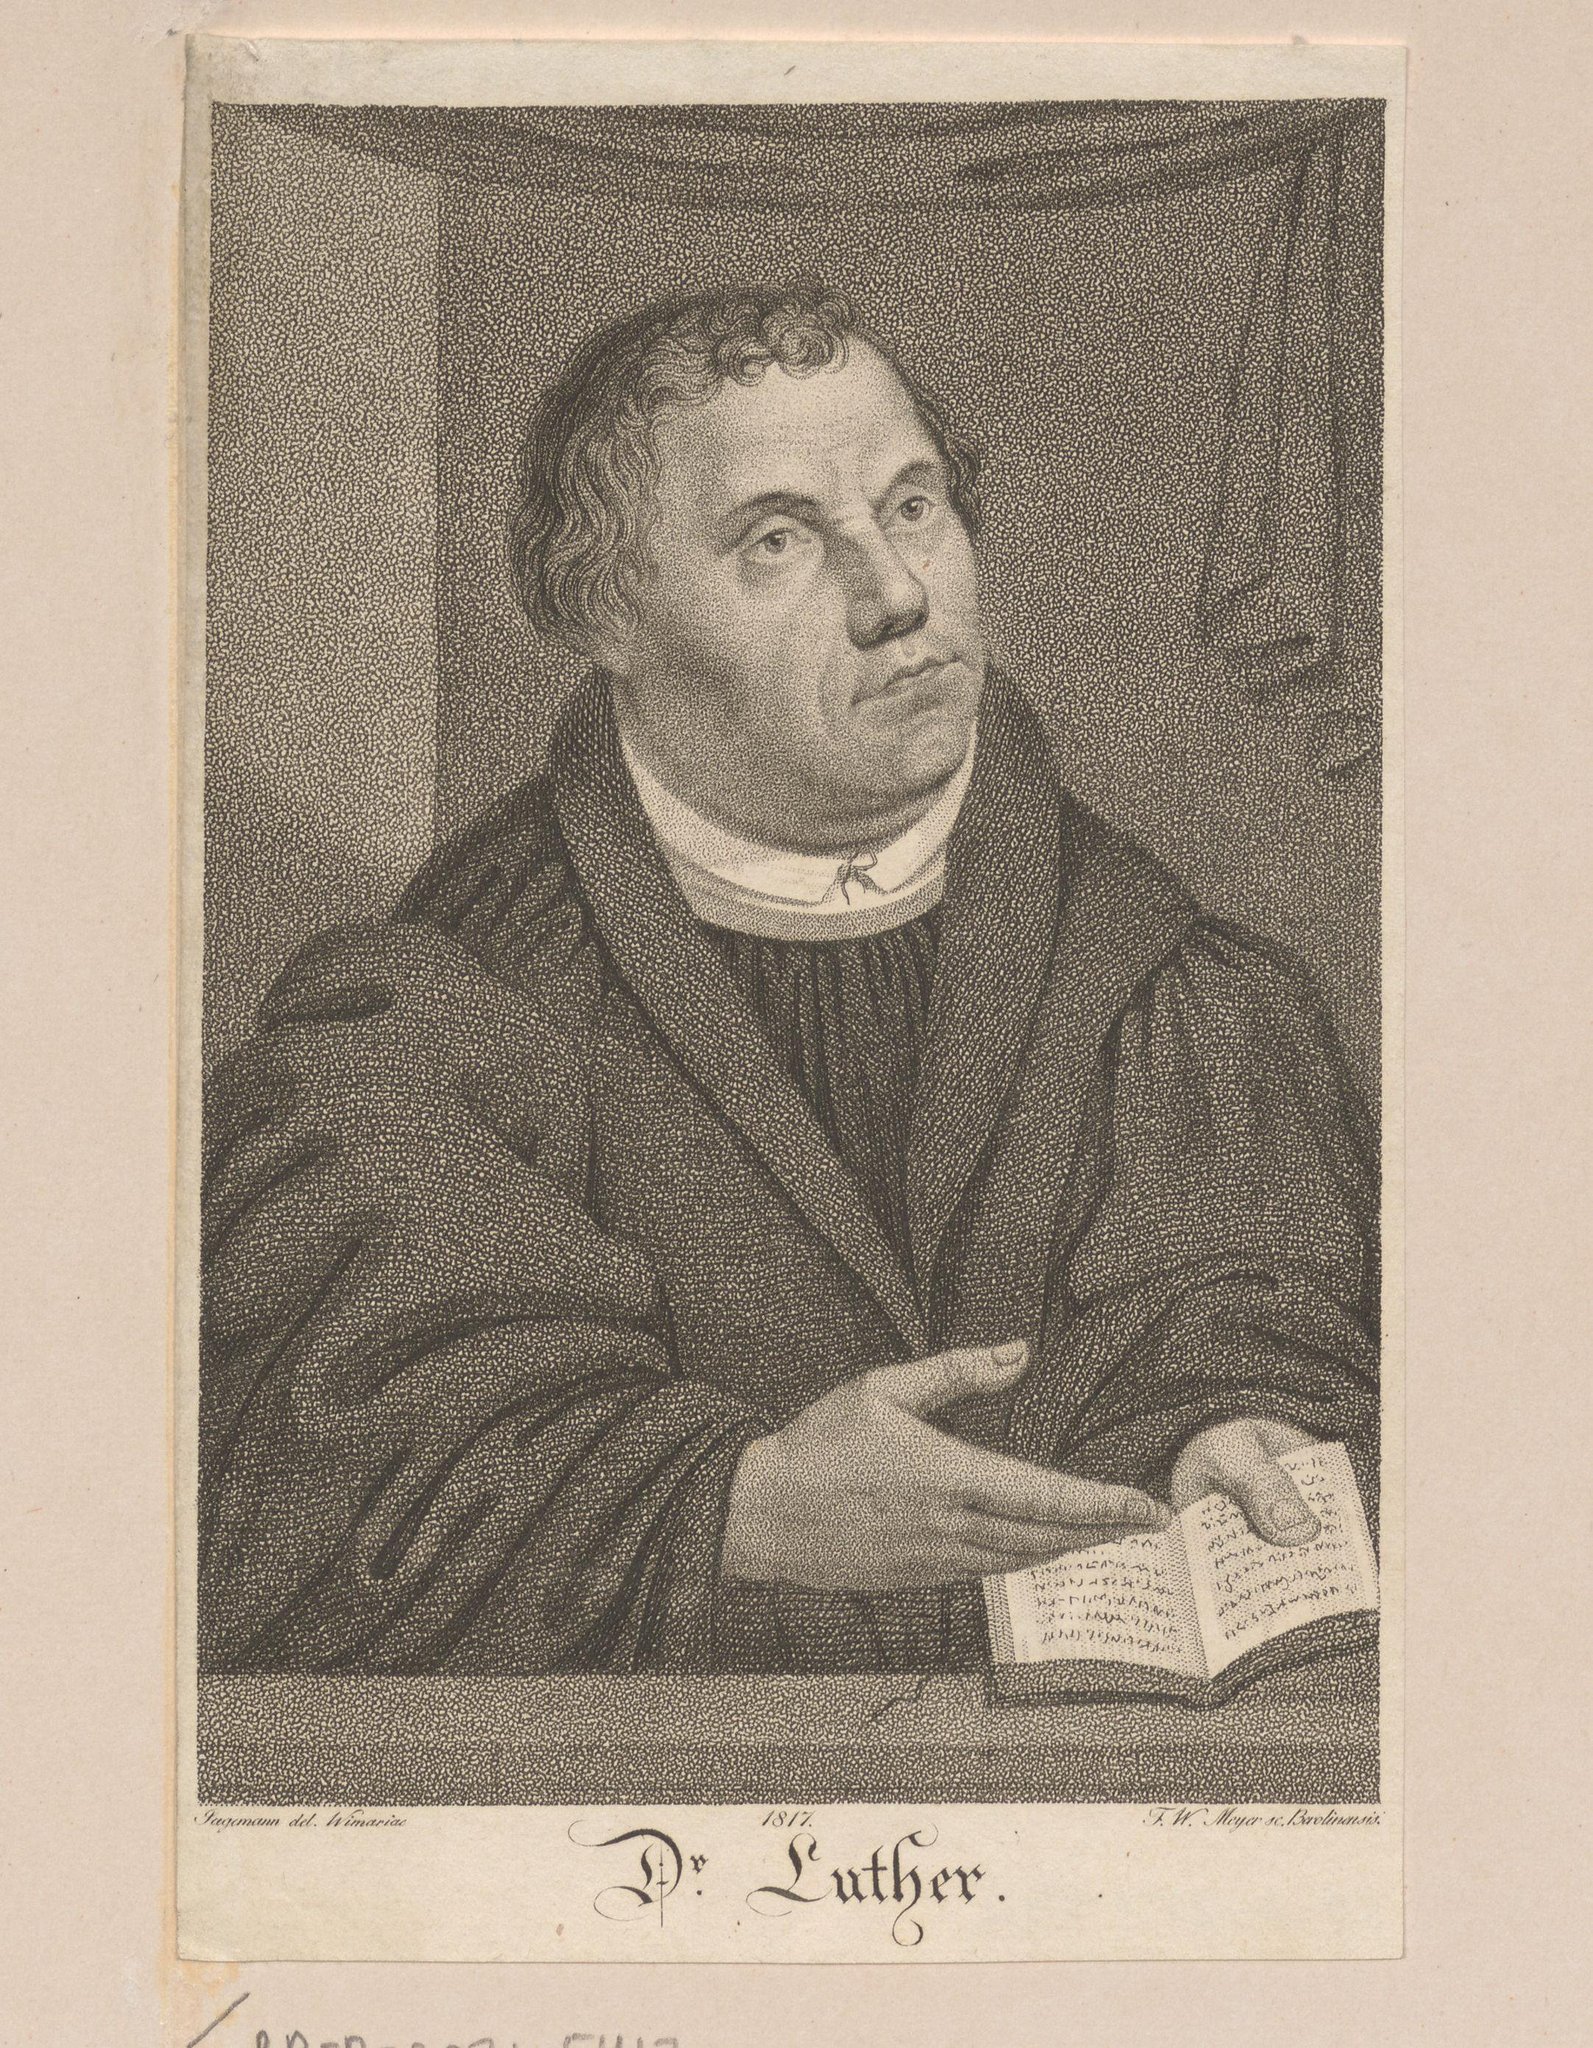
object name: print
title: Portret van Martin Luther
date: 1817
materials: paper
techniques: aquatint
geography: germany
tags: martin luther, theologian, historical persons, book - mm - book open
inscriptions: date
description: Prent waarschijnlijk uit: Reformations-Almanach für Luthers Verehrer auf das evangelische Jubeljahr 1817. Erfurt: Friedrich Keyser, 1817.